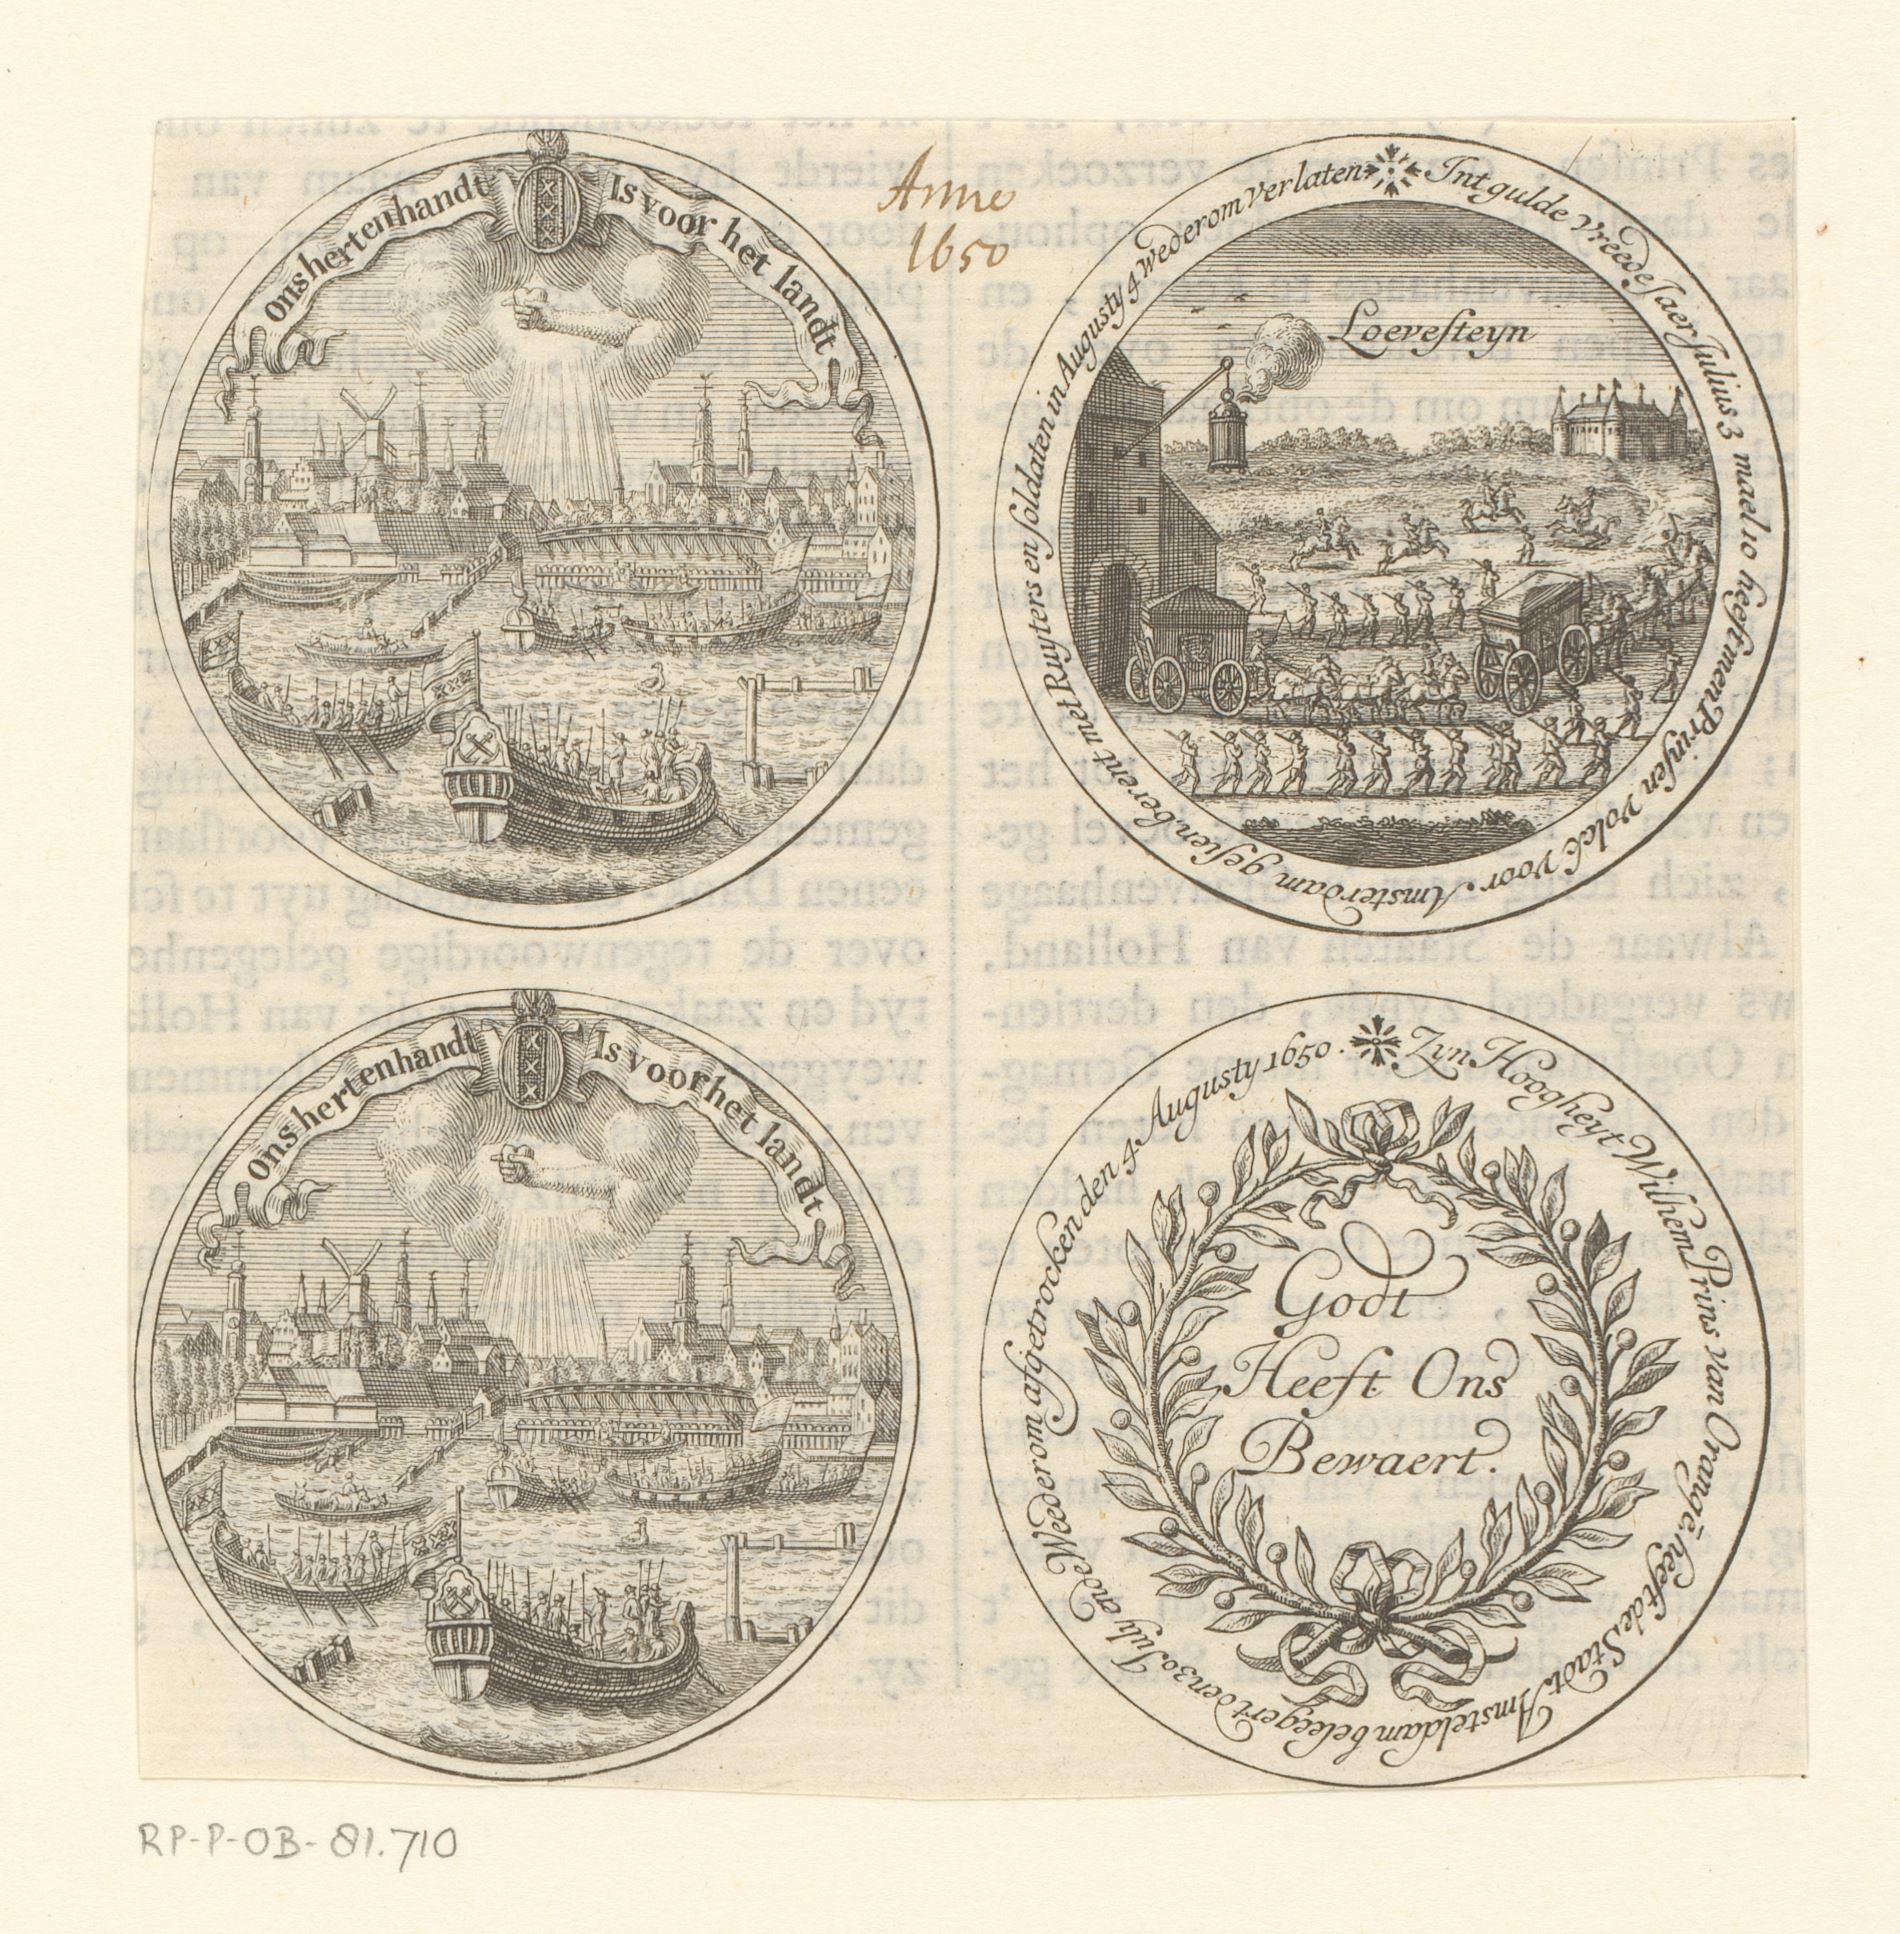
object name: historical object representation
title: Twee penningen op het beleg van Amsterdam door Willem II, 1650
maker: Anonymous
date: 1724-1726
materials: paper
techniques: etching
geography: northern netherlands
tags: william ii (prince of orange), medal (considered as a piece of sculpture, regardless of its specific function), loevestein castle, amsterdam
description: Twee penningen over de gebeurtenissen te Amsterdam in het jaar 1650. Bovenste penning: voorzijde: boten met soldaten op de Amstel, uit de wolken steekt een hand met een hart. Keerzijde: de gearresteerde statenleden worden naar Loevestein gebracht. Onderste penning: voorzijde: boten met soldaten op de Amstel, uit de wolken steekt een hand met een hart. Keerzijde: omkranste opschrift: Godt Heeft Ons Bewaert. Uitgeknipte illustratie bedrukt met tekst op achterzijde.